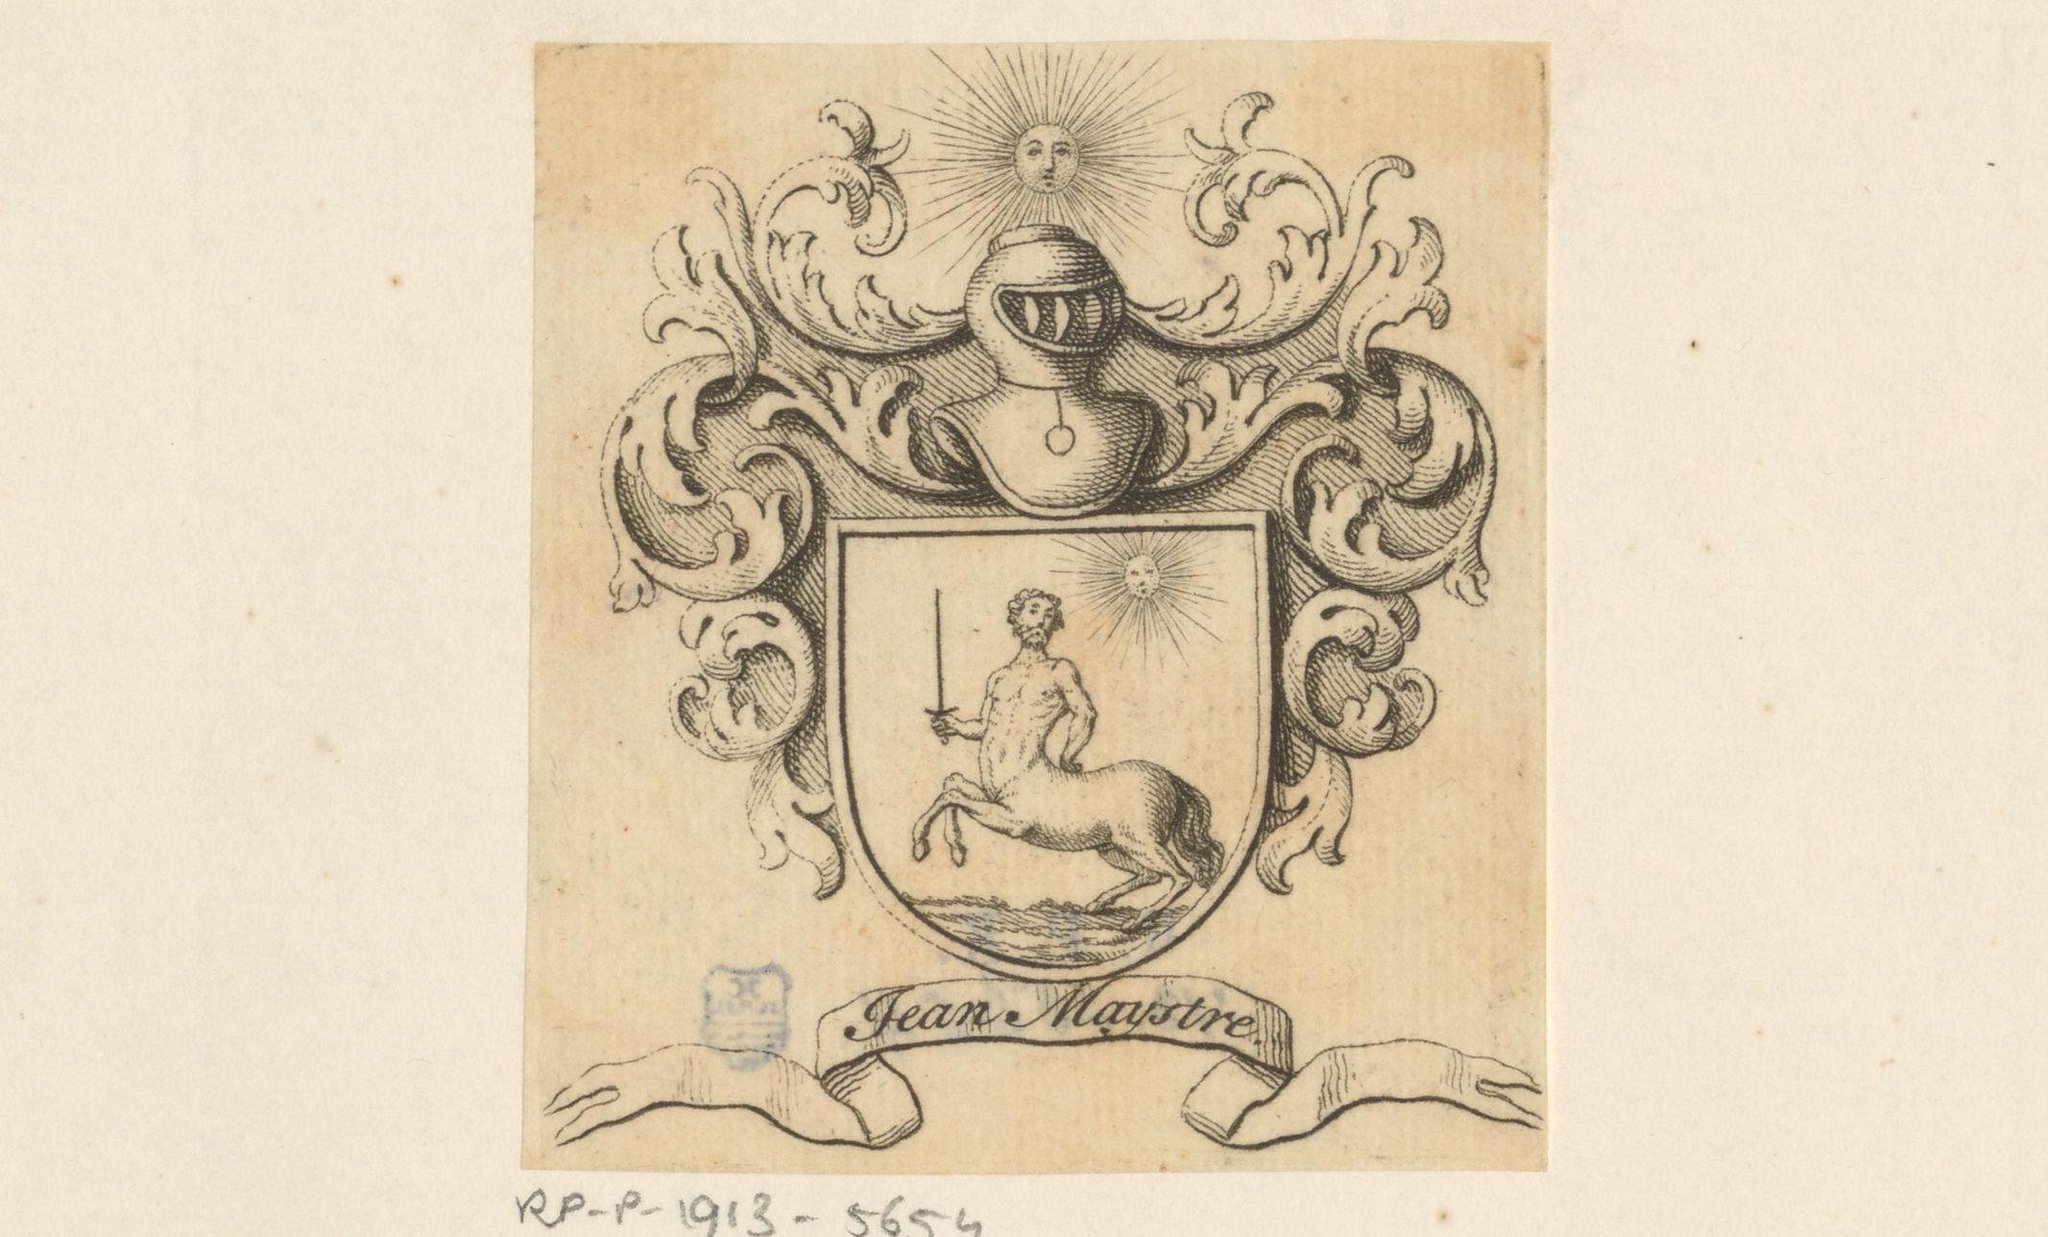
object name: bookplate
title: Ex libris van Jean Maystre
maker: Anonymous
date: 1600-1749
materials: paper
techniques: etching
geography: france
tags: centaurs, sun as celestial body, armorial bearing, heraldry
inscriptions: collector's mark: Lugt 2233, collector's mark: Lugt 2760